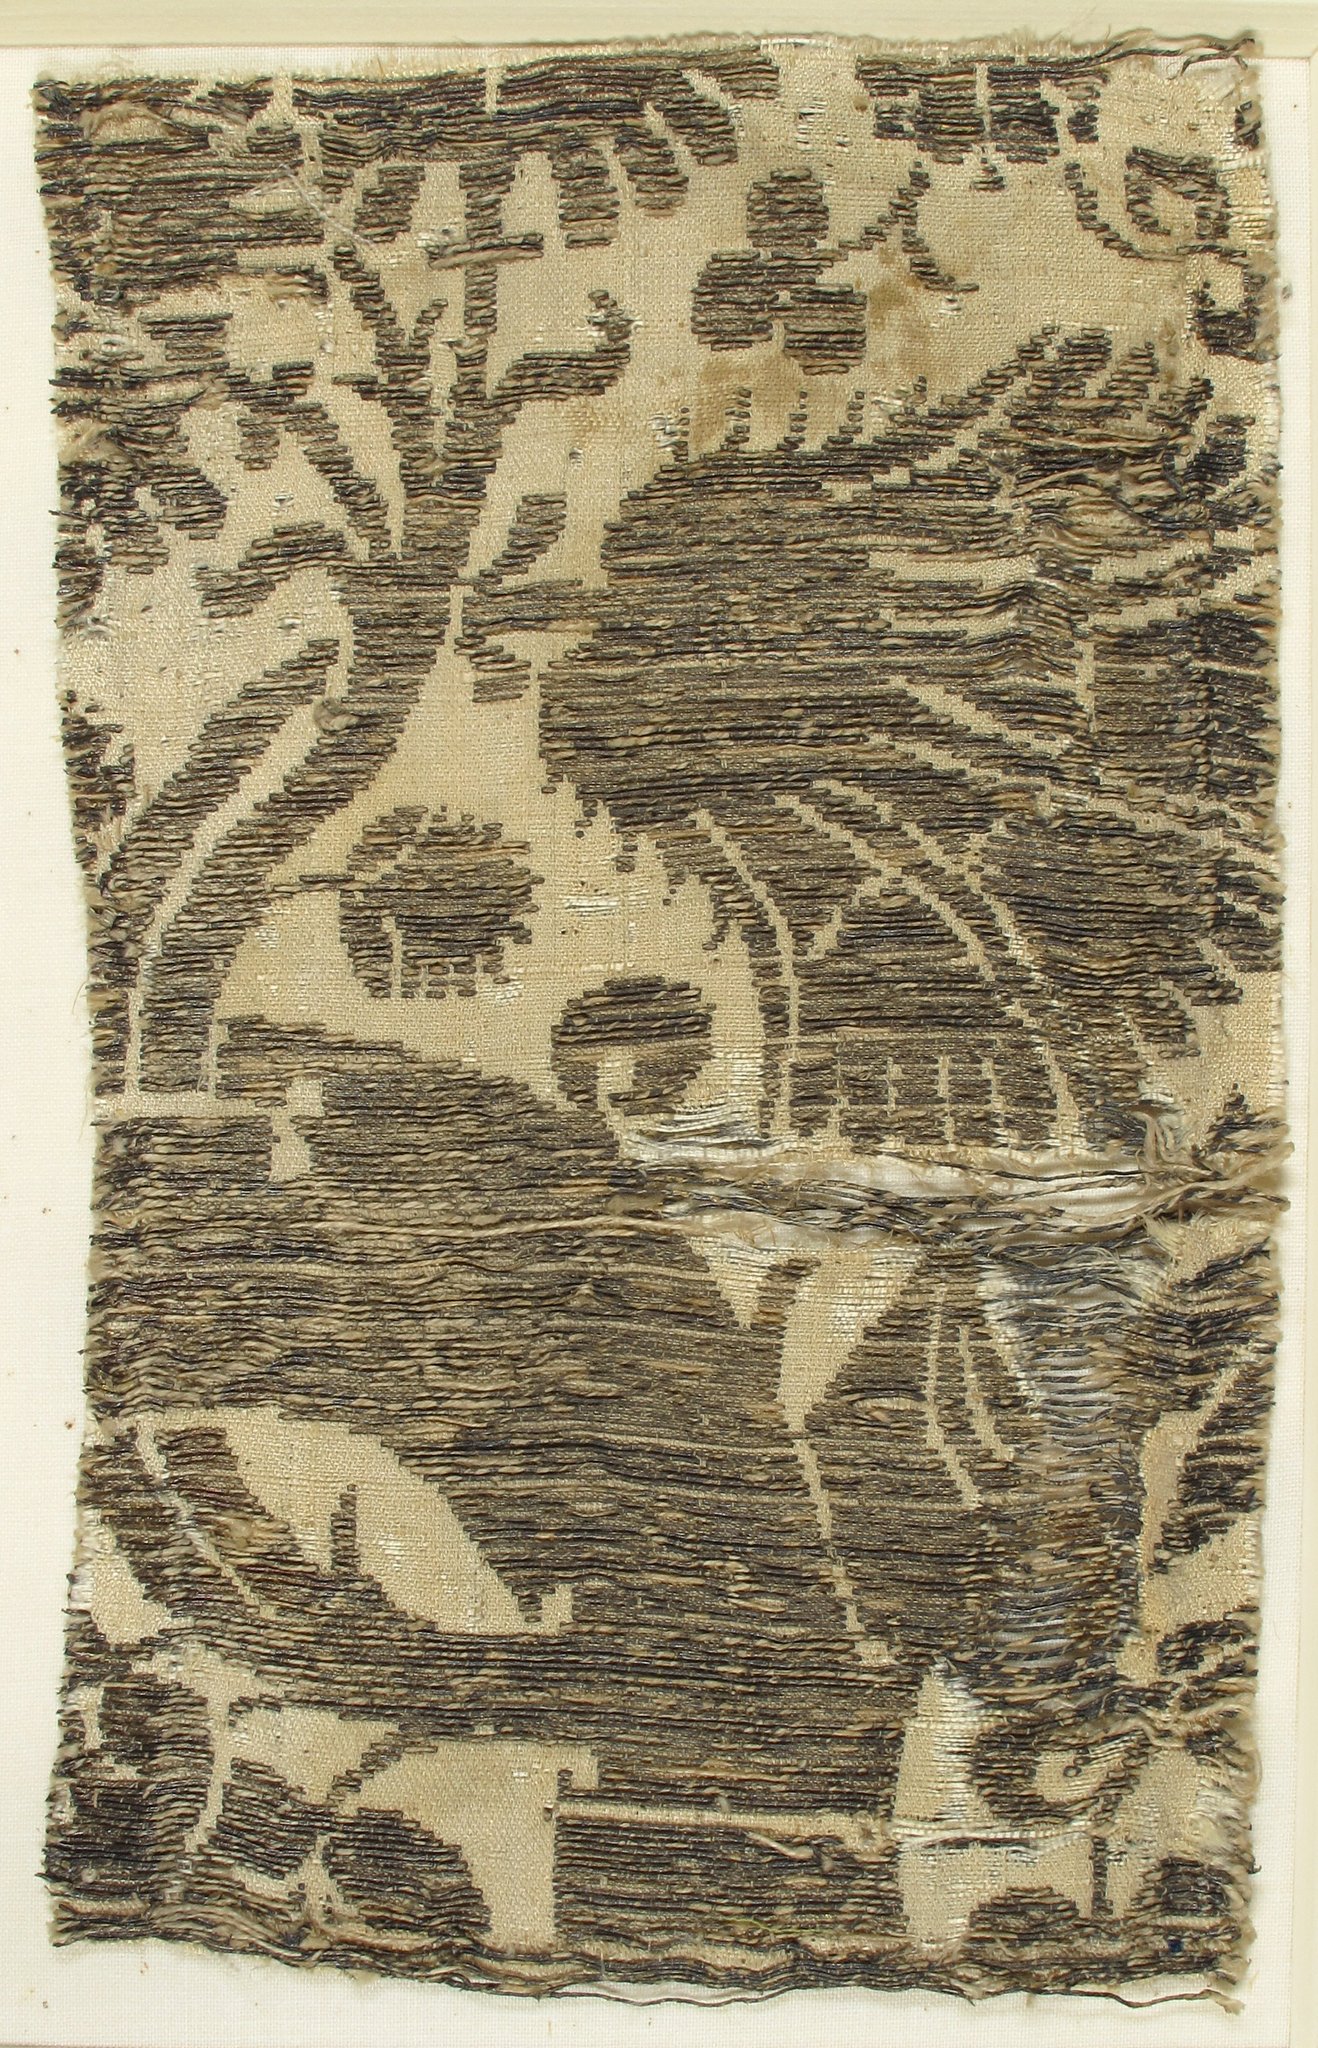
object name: textile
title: Textile with Brocade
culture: italian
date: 1301-1400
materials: gold thread, silk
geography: italy